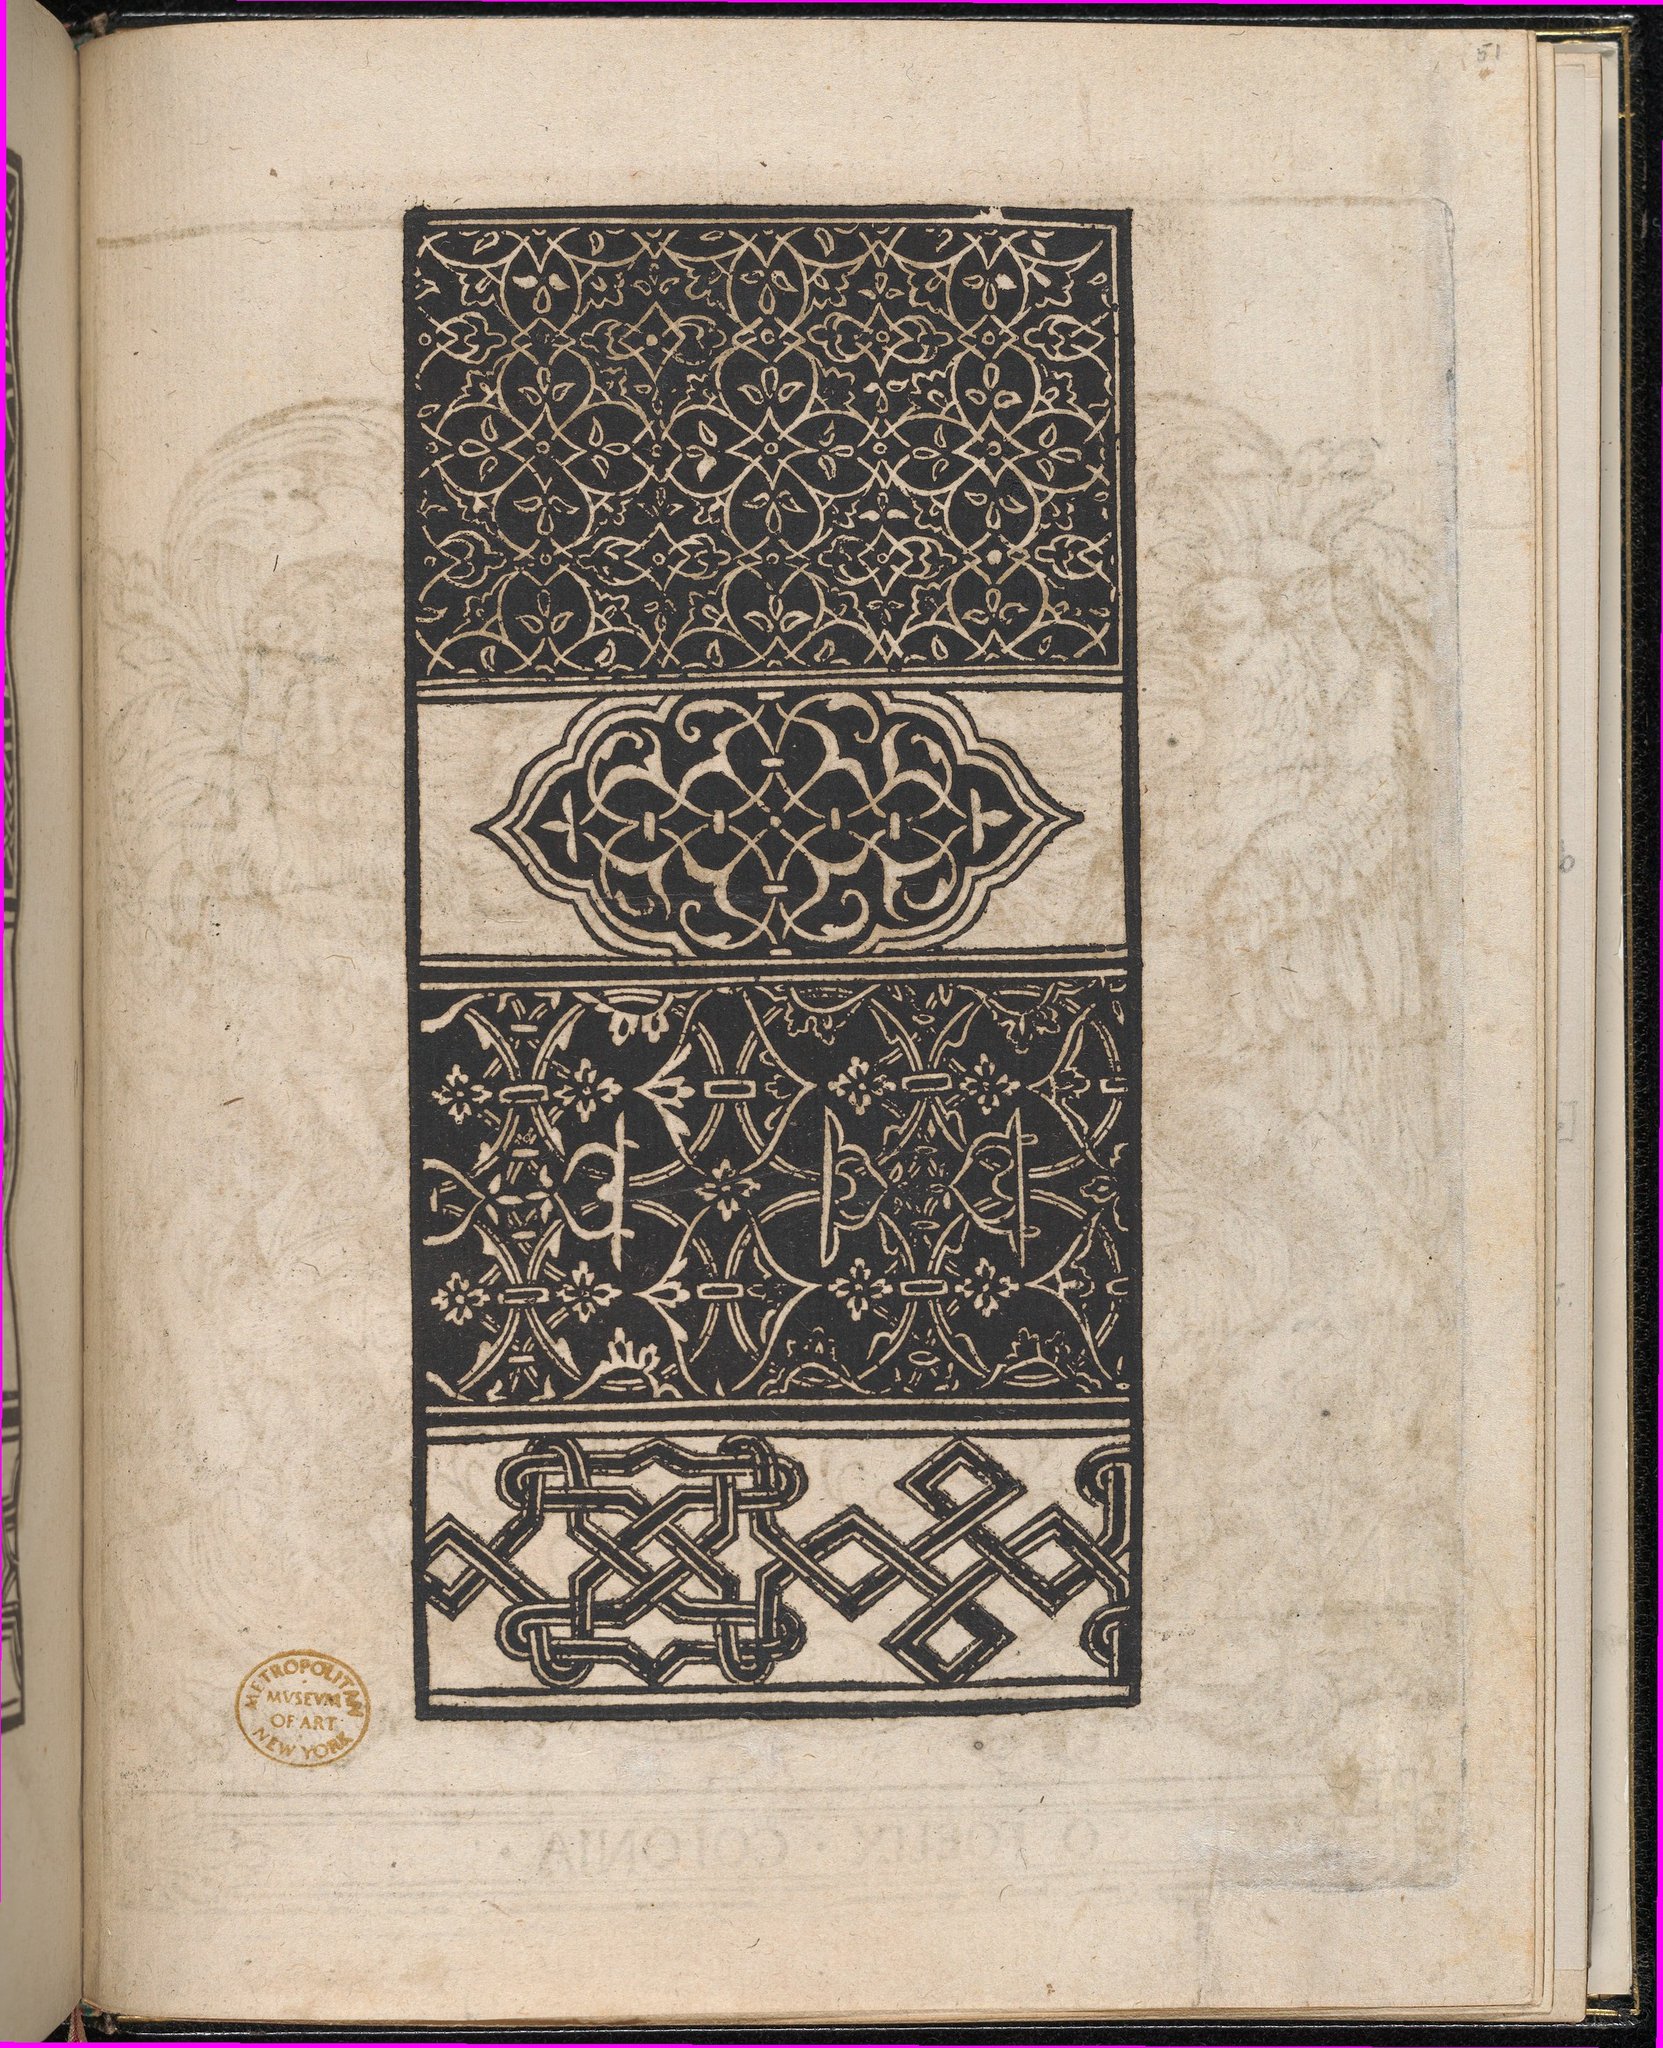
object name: book print ornament architecture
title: Page from Ein new kunstlich Modelbuch...(Page 51r)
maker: peter quentel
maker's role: publisher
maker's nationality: german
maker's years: 1500-1550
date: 1544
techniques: woodcut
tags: ornament